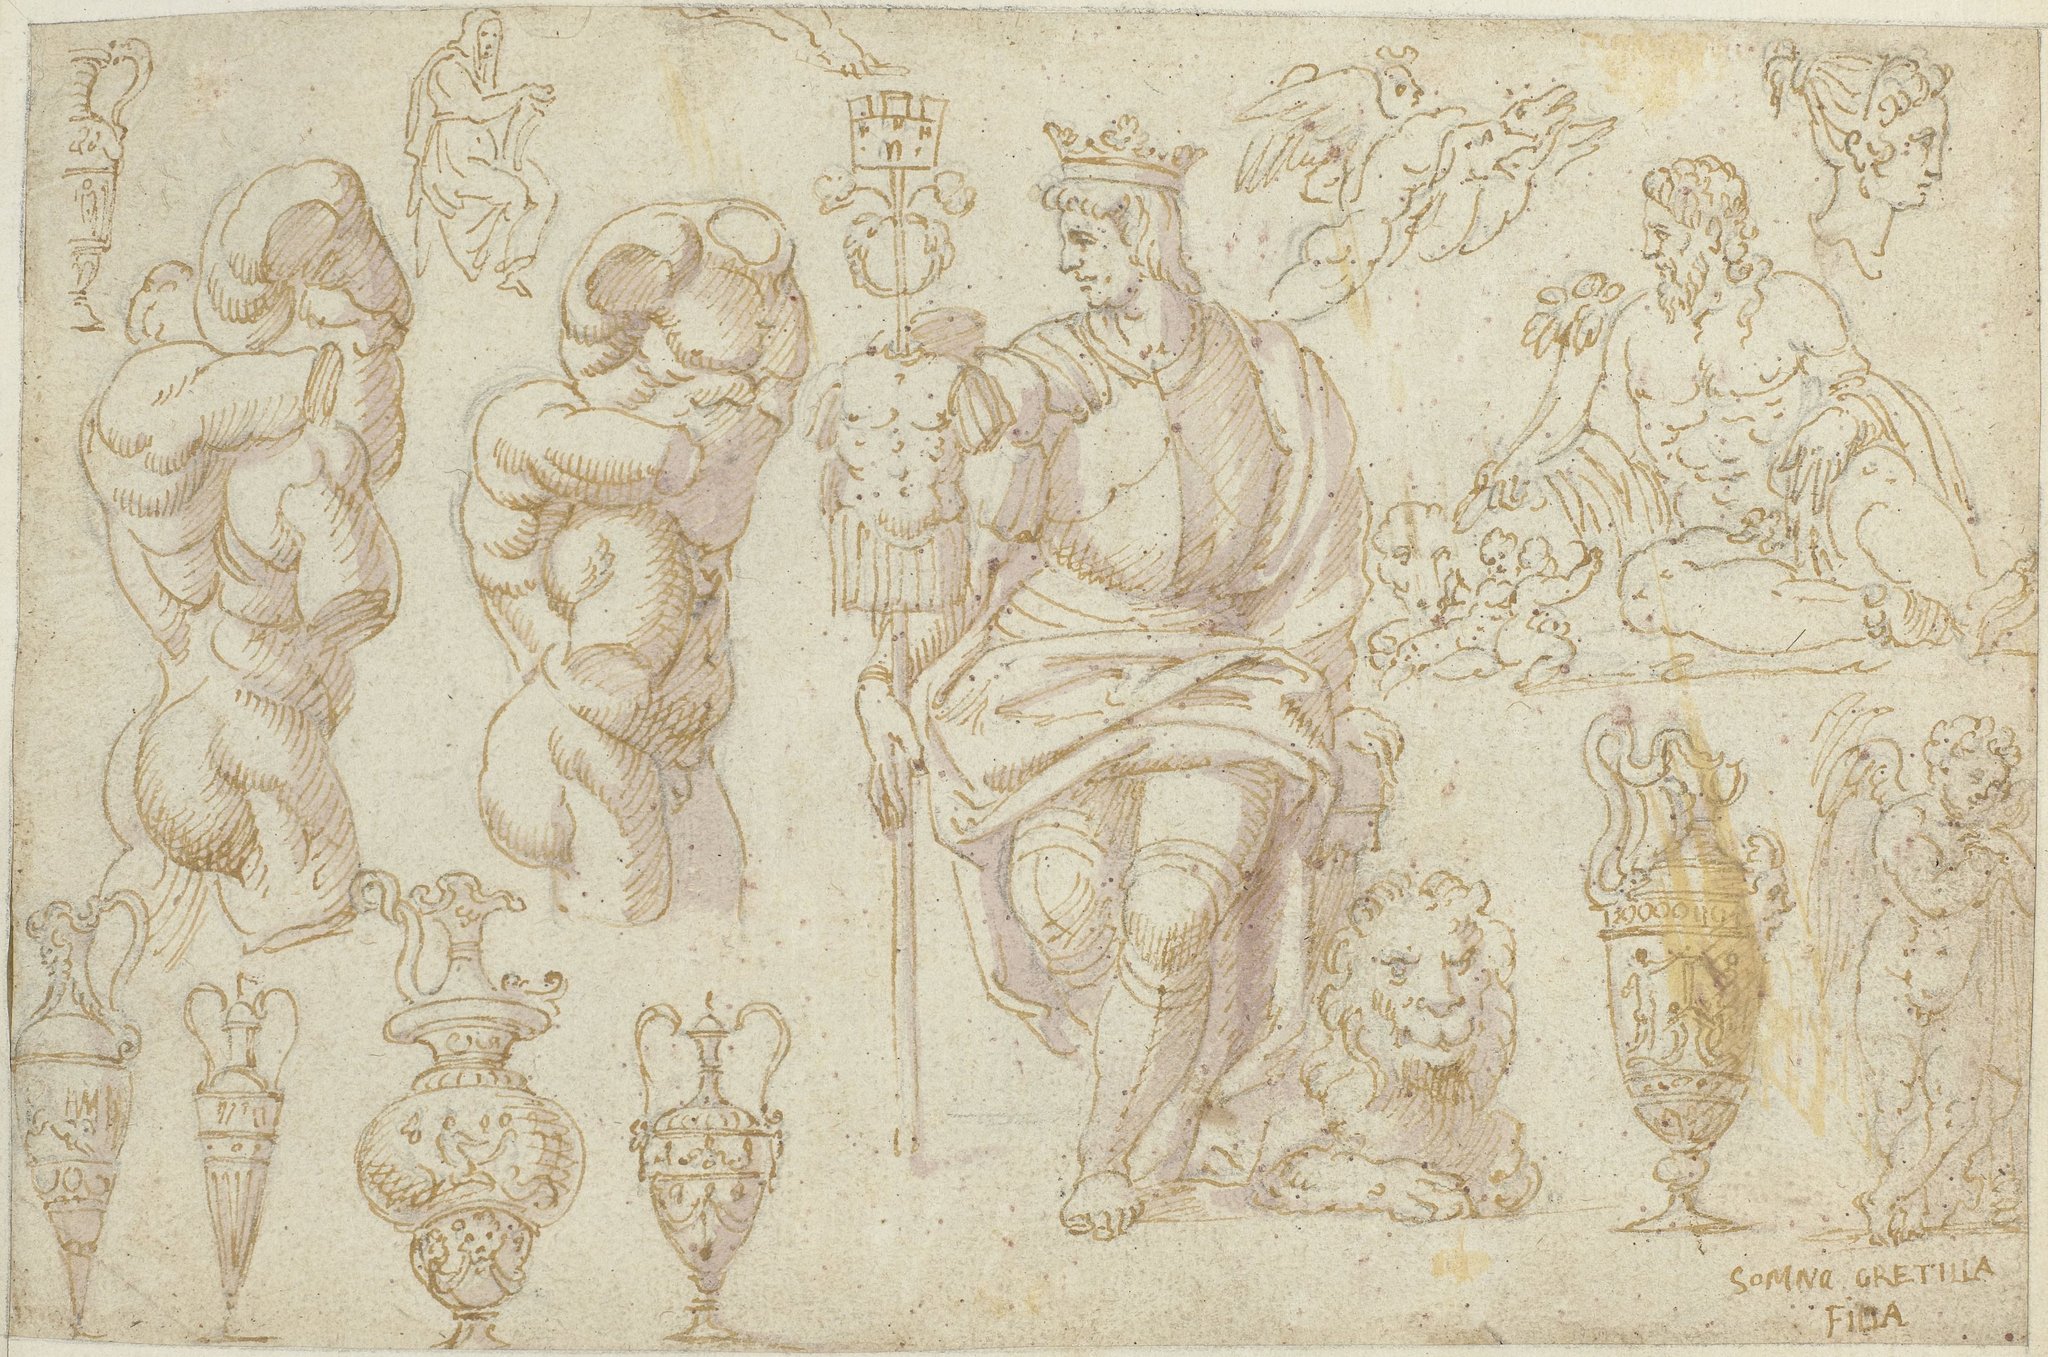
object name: kopie naar fresco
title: Beelden, een fresco en een tekening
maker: Anonymous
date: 1550-1570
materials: chalk, ink, paper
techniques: brush, pen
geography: low countries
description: Album "Maarten de Vos schetsboek", blad 8r(12).